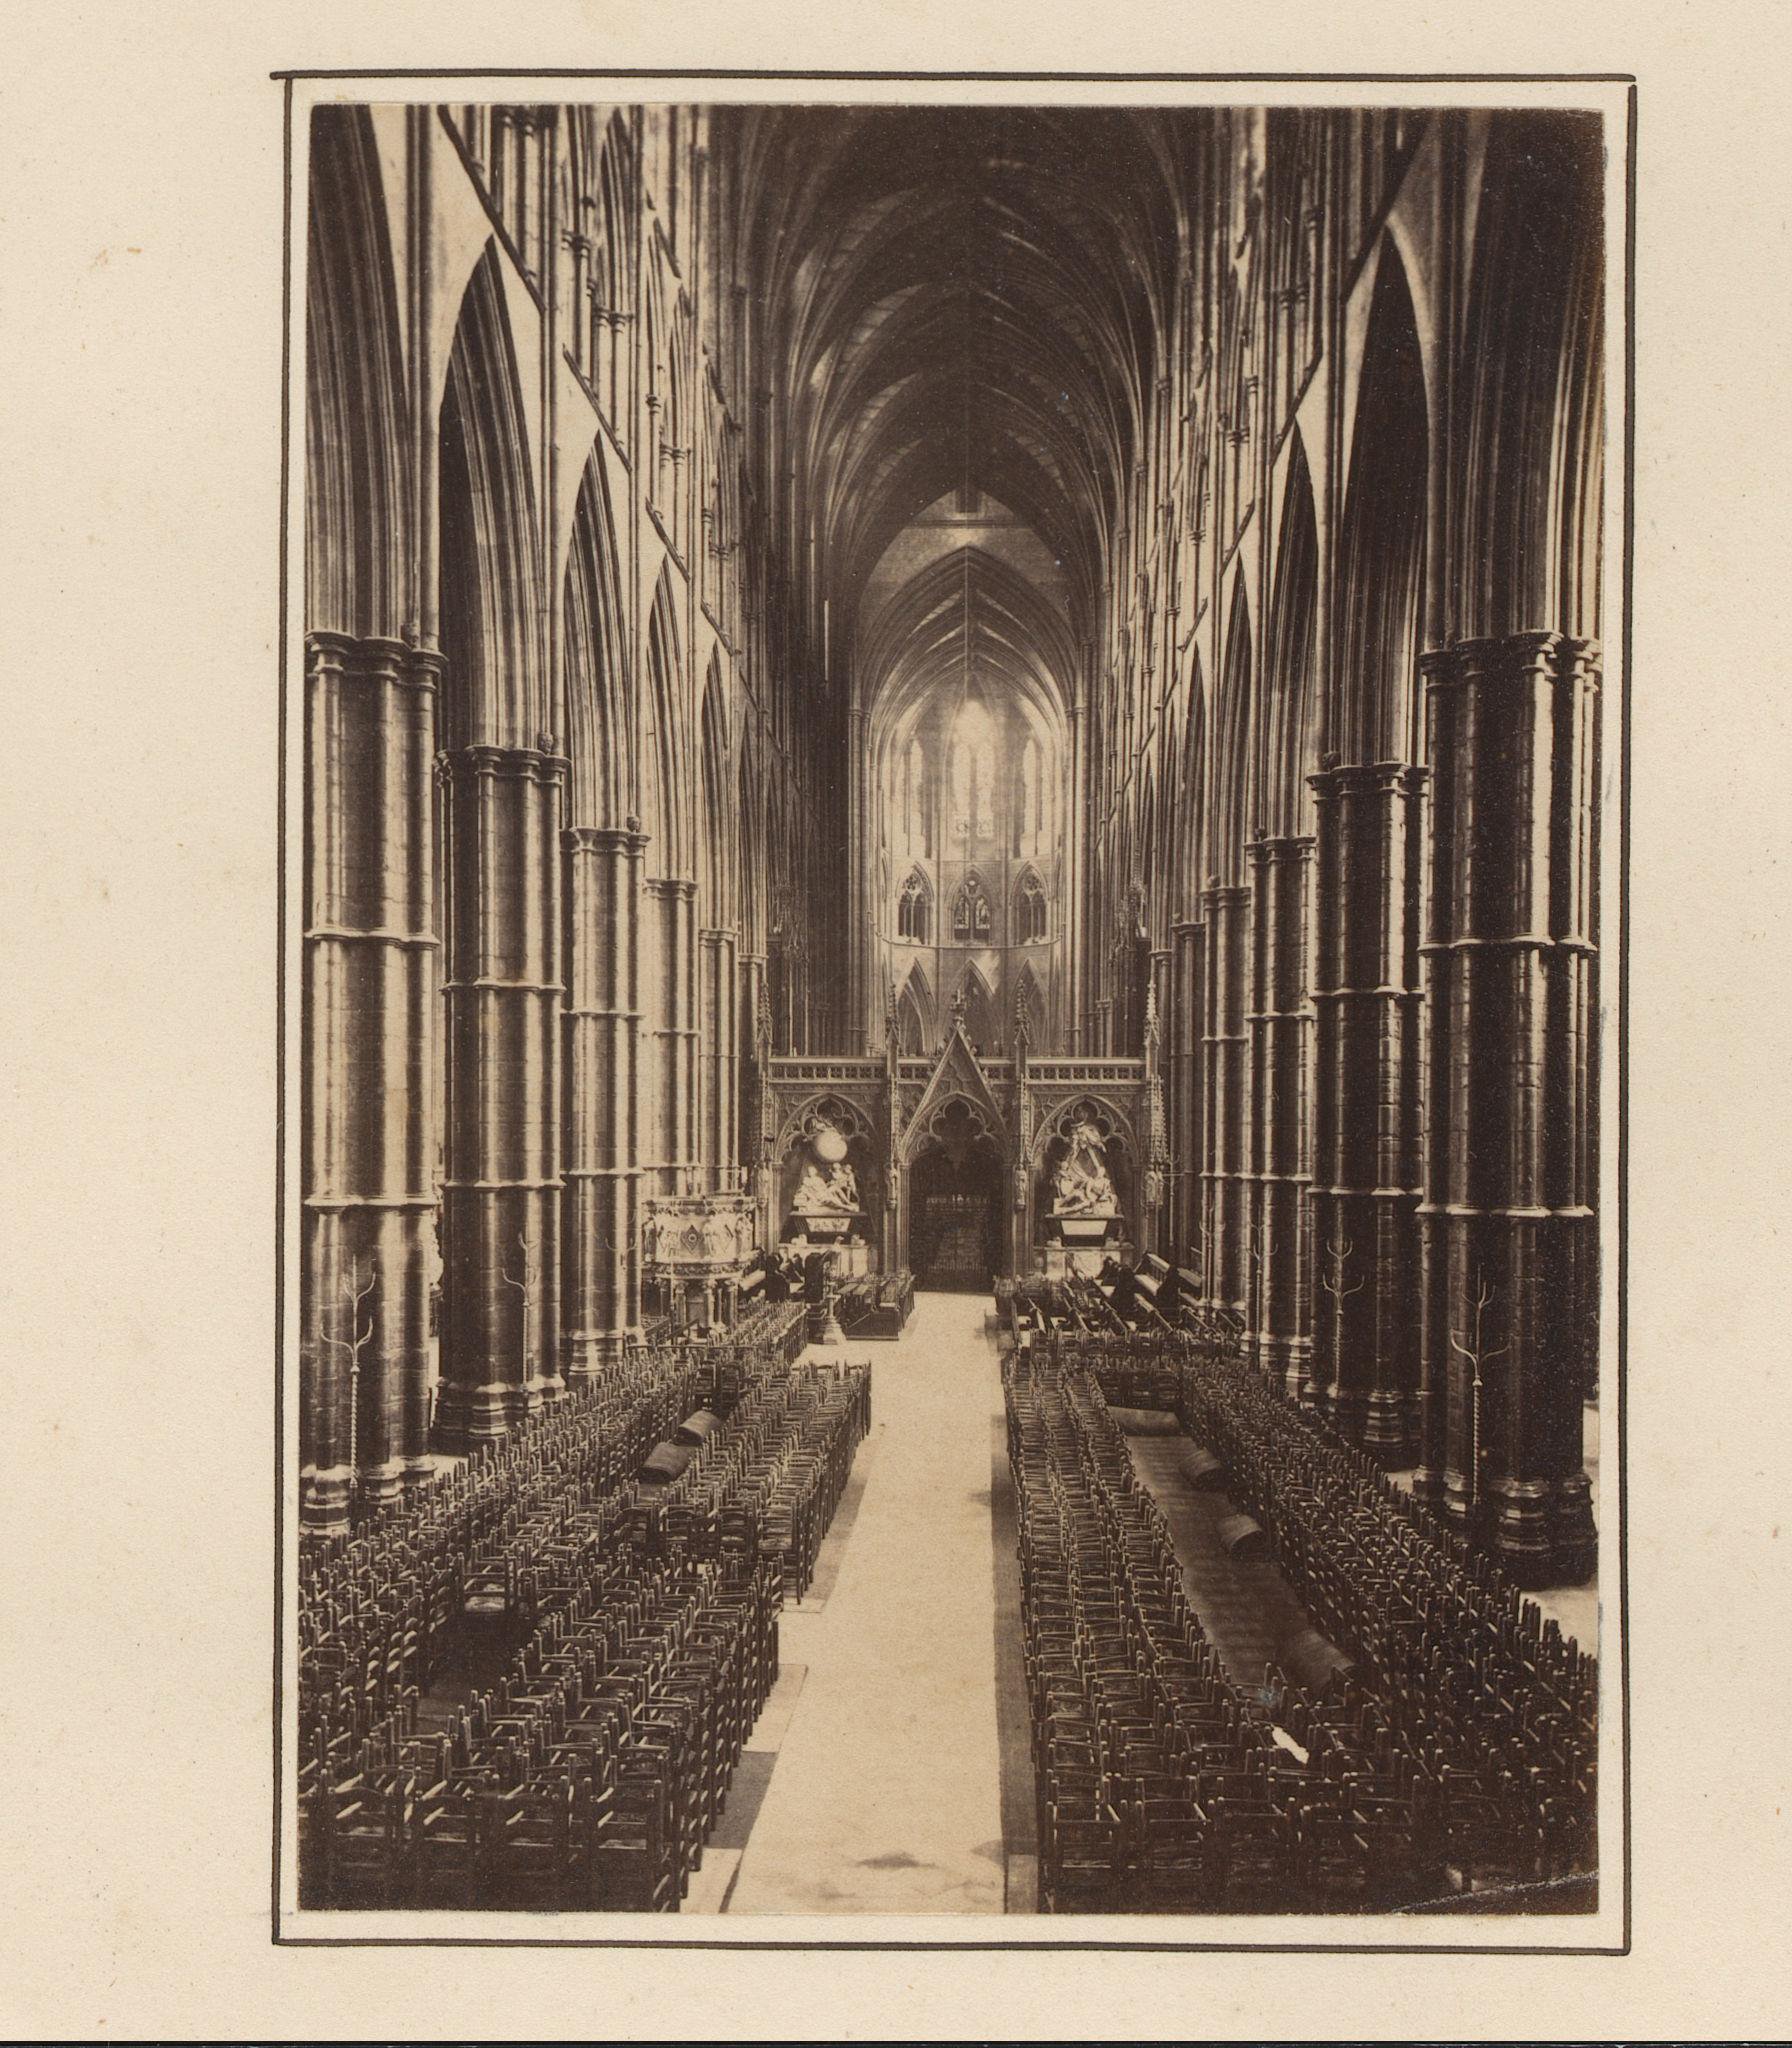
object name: photograph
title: Westminster Abbey - Nave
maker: Anonymous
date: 1870-1890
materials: paper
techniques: albumen print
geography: westminster abbey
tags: parts of church interior: nave, westminster abbey